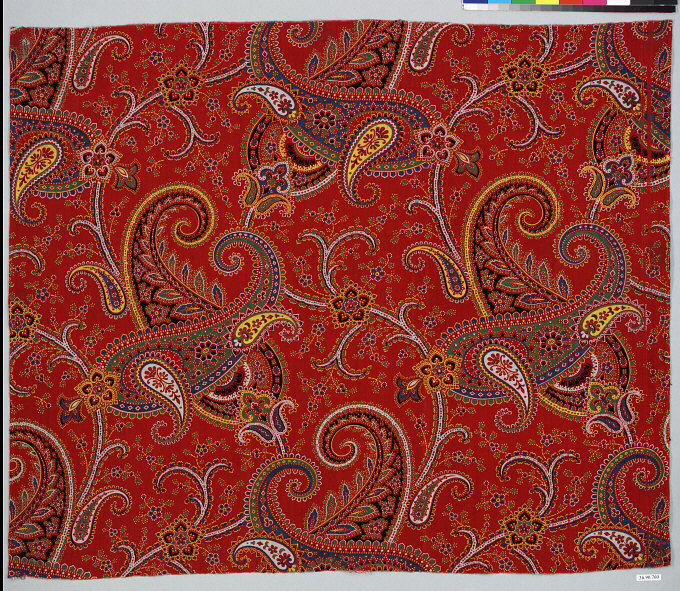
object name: piece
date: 1867-1900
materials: cotton